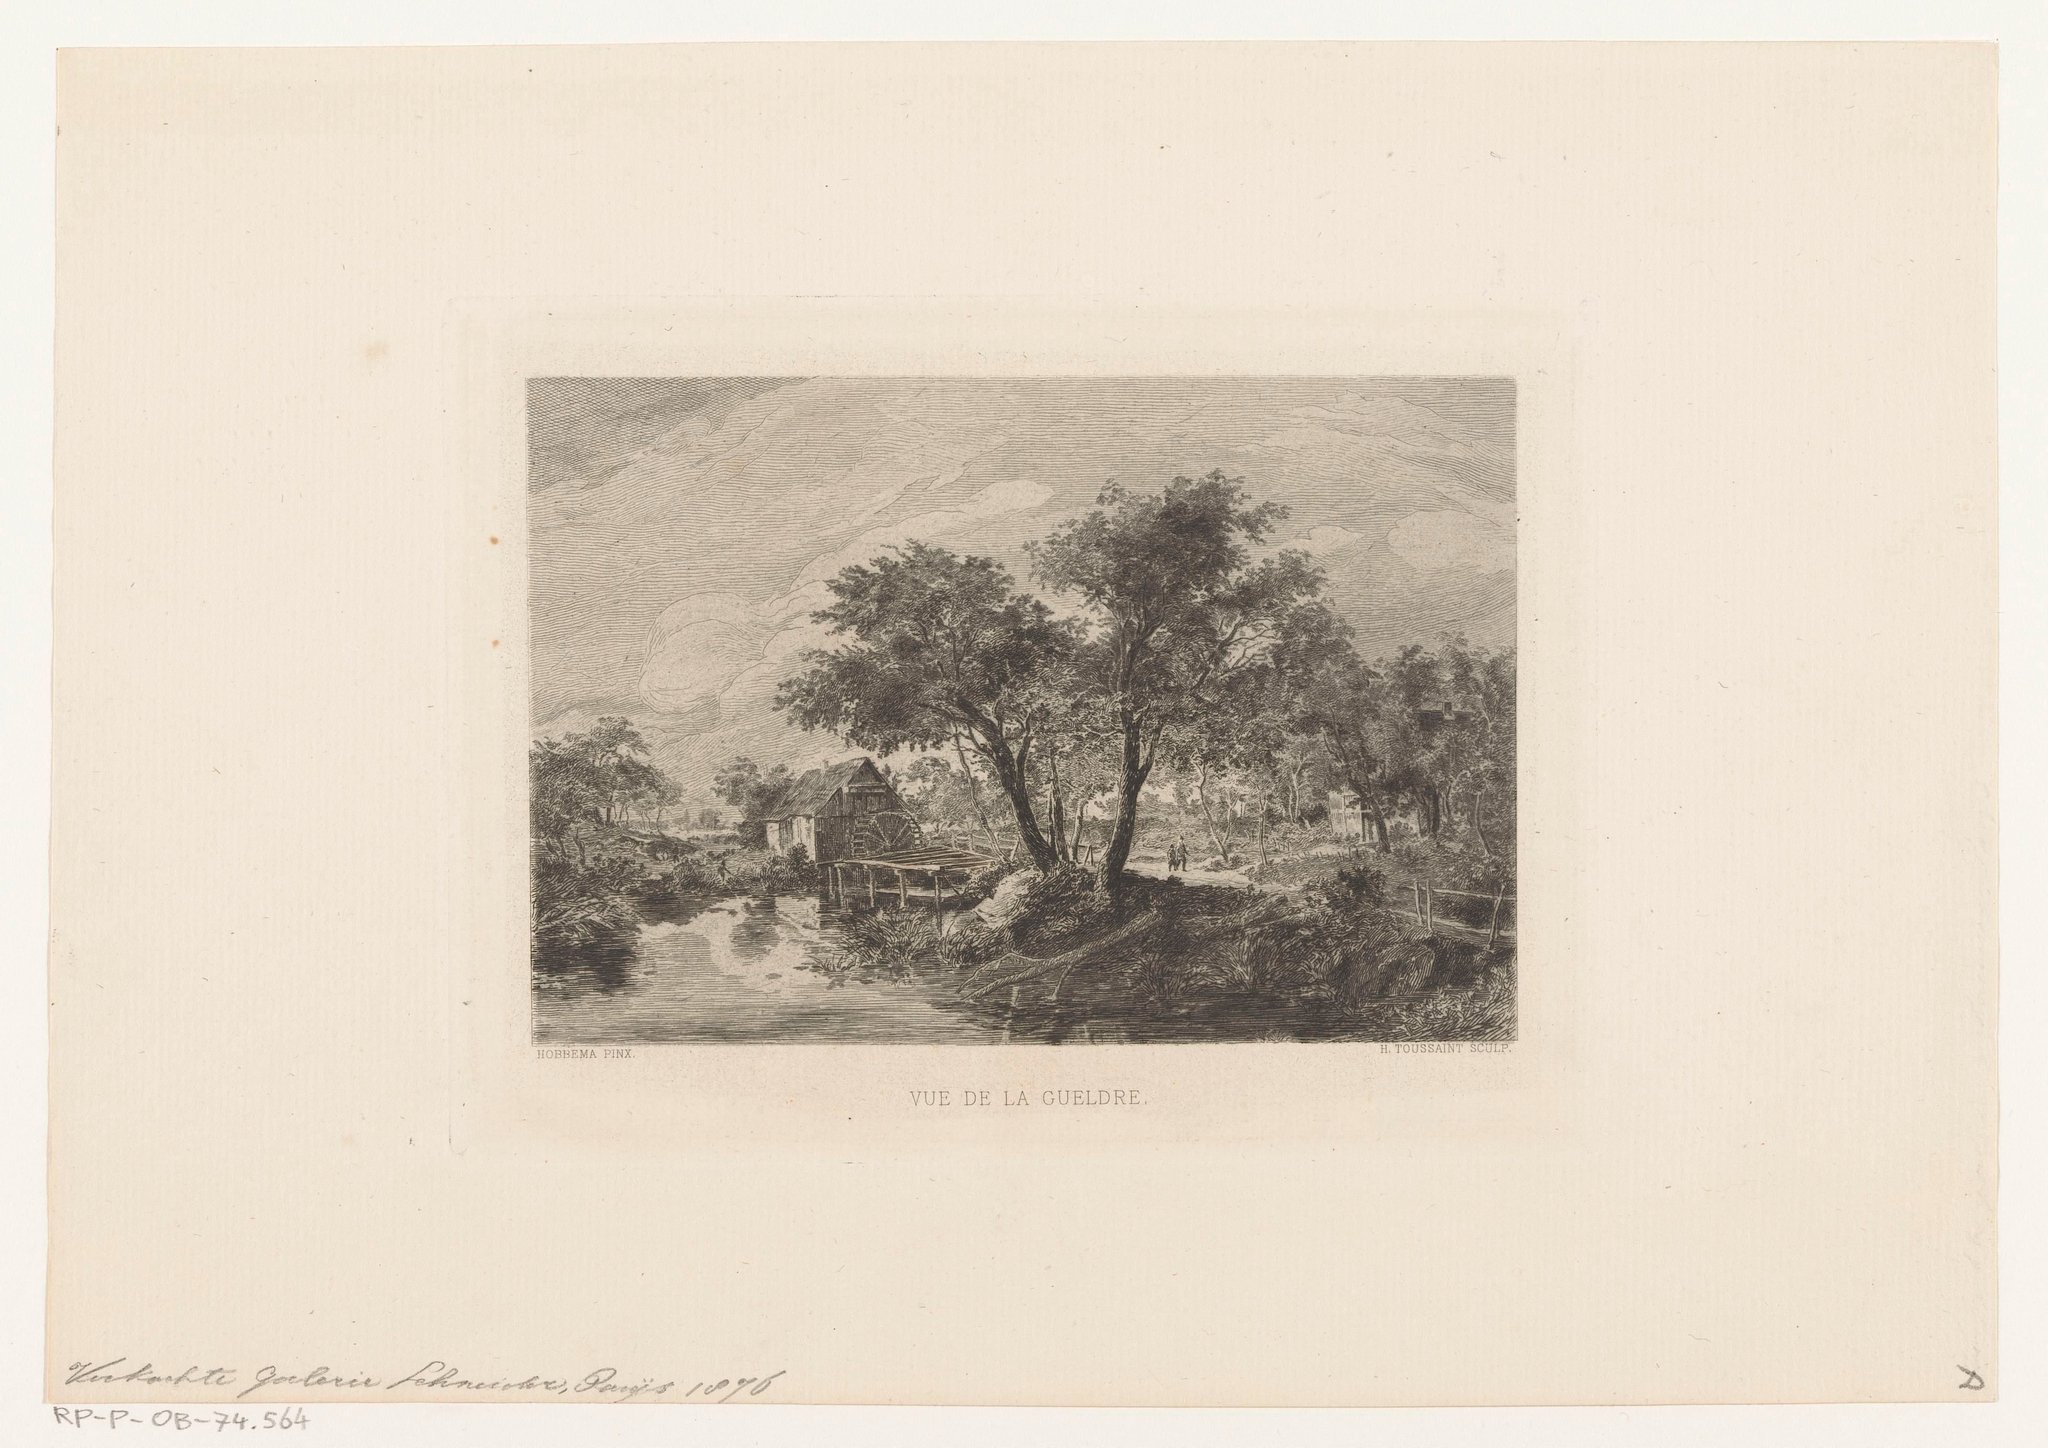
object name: print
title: Rivierlandschap met bomen en waterrad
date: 1859-1911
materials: paper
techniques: etching, intaglio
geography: paris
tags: river, paddle wheel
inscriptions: collector's mark: Lugt 2228